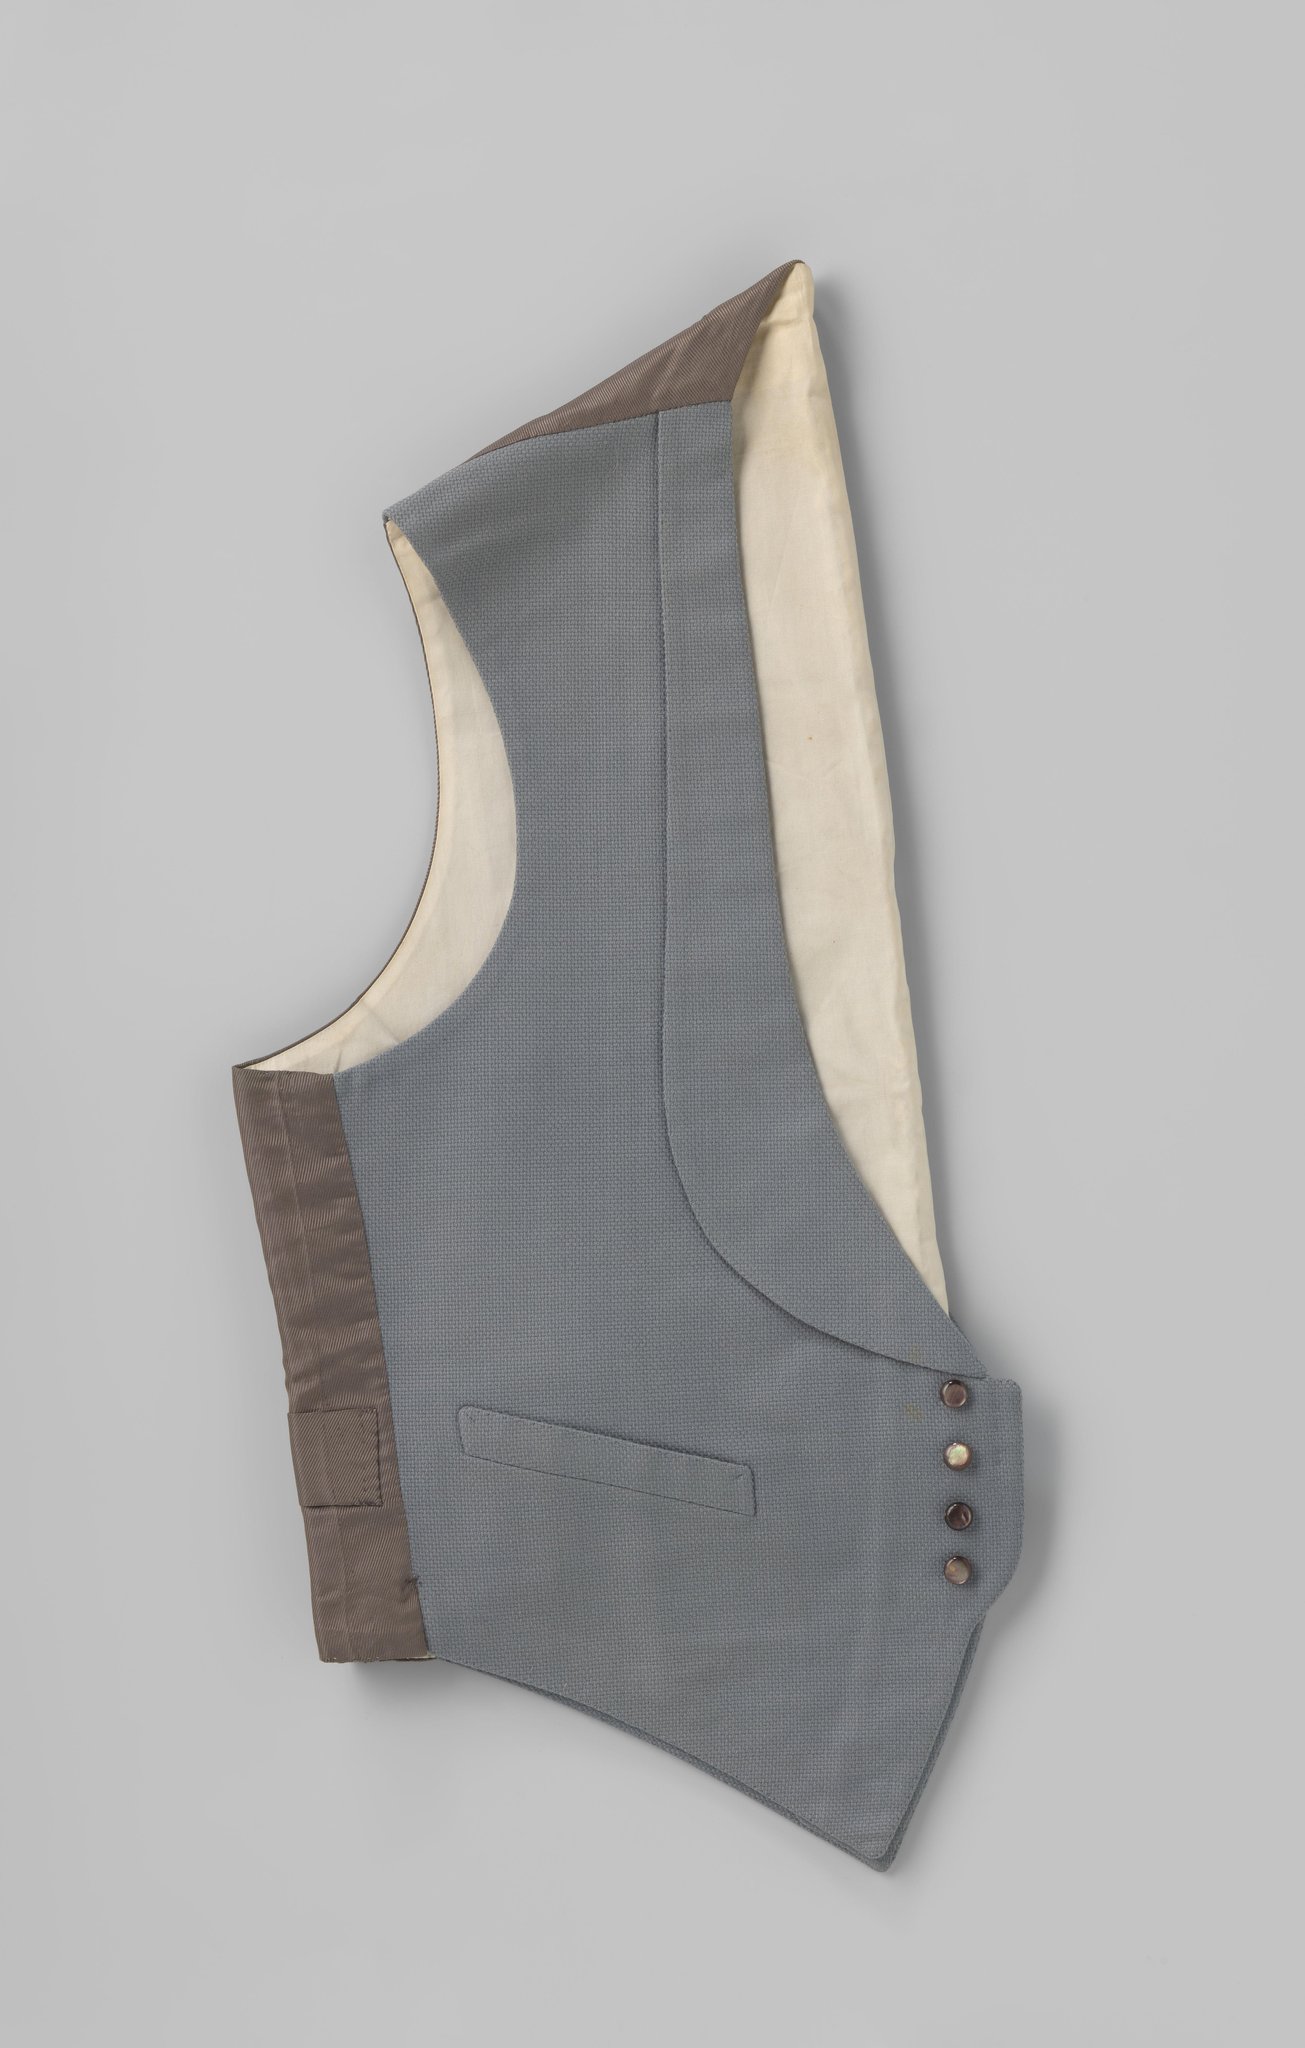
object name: menswear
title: Vest van grijze wol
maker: Anonymous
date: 1926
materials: wool